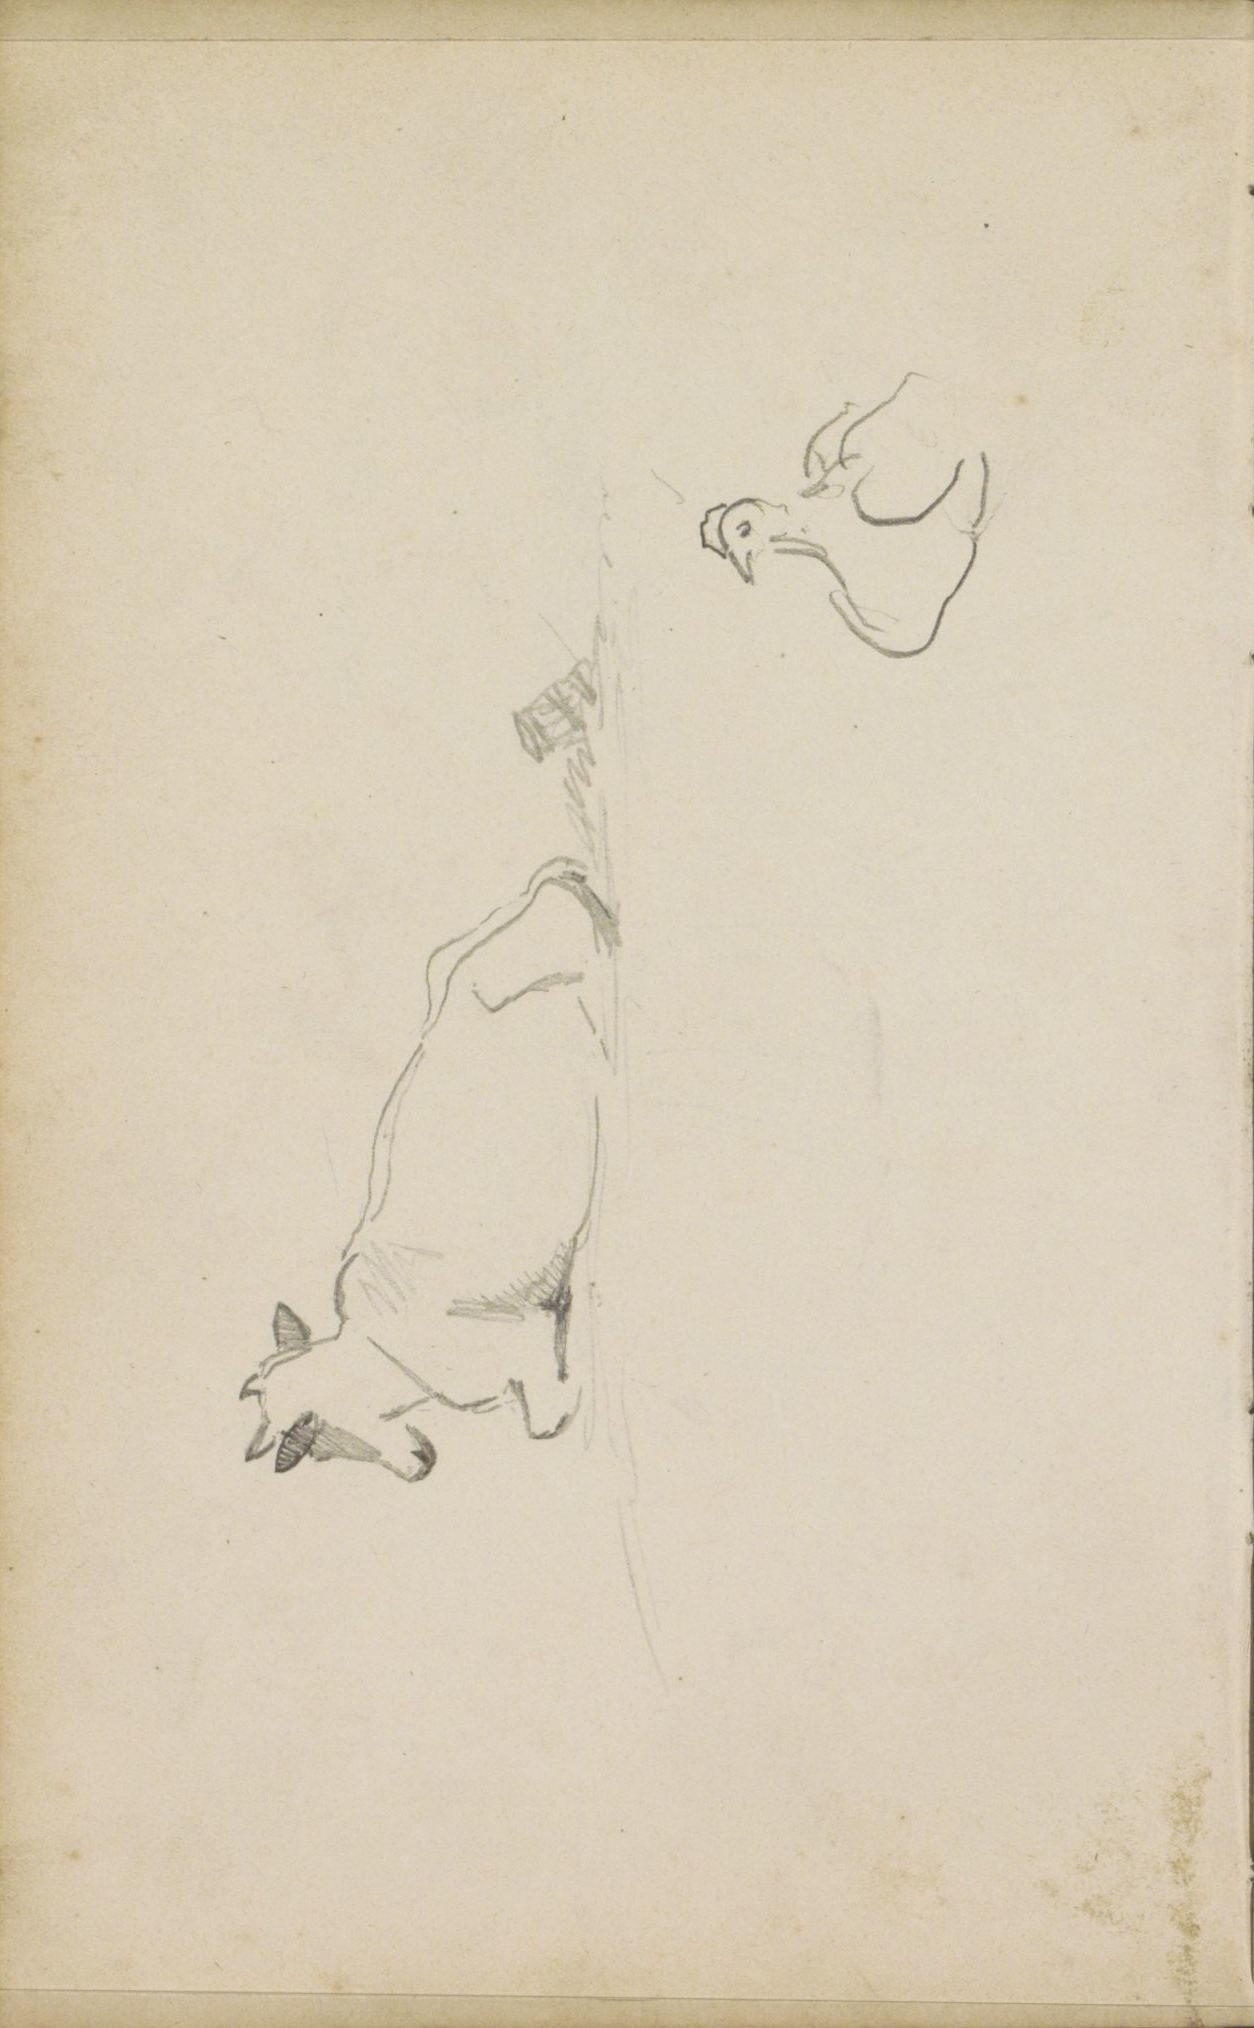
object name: sketchbook leaf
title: Liggende geit en een kip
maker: johannes tavenraat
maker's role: draughtsman, painter, print maker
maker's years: 1809-1881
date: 1839-1872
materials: paper, pencil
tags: fowl (cock, hen, chicken, etc.), goat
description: Blad 17 verso uit een schetsboek met 73 bladen.